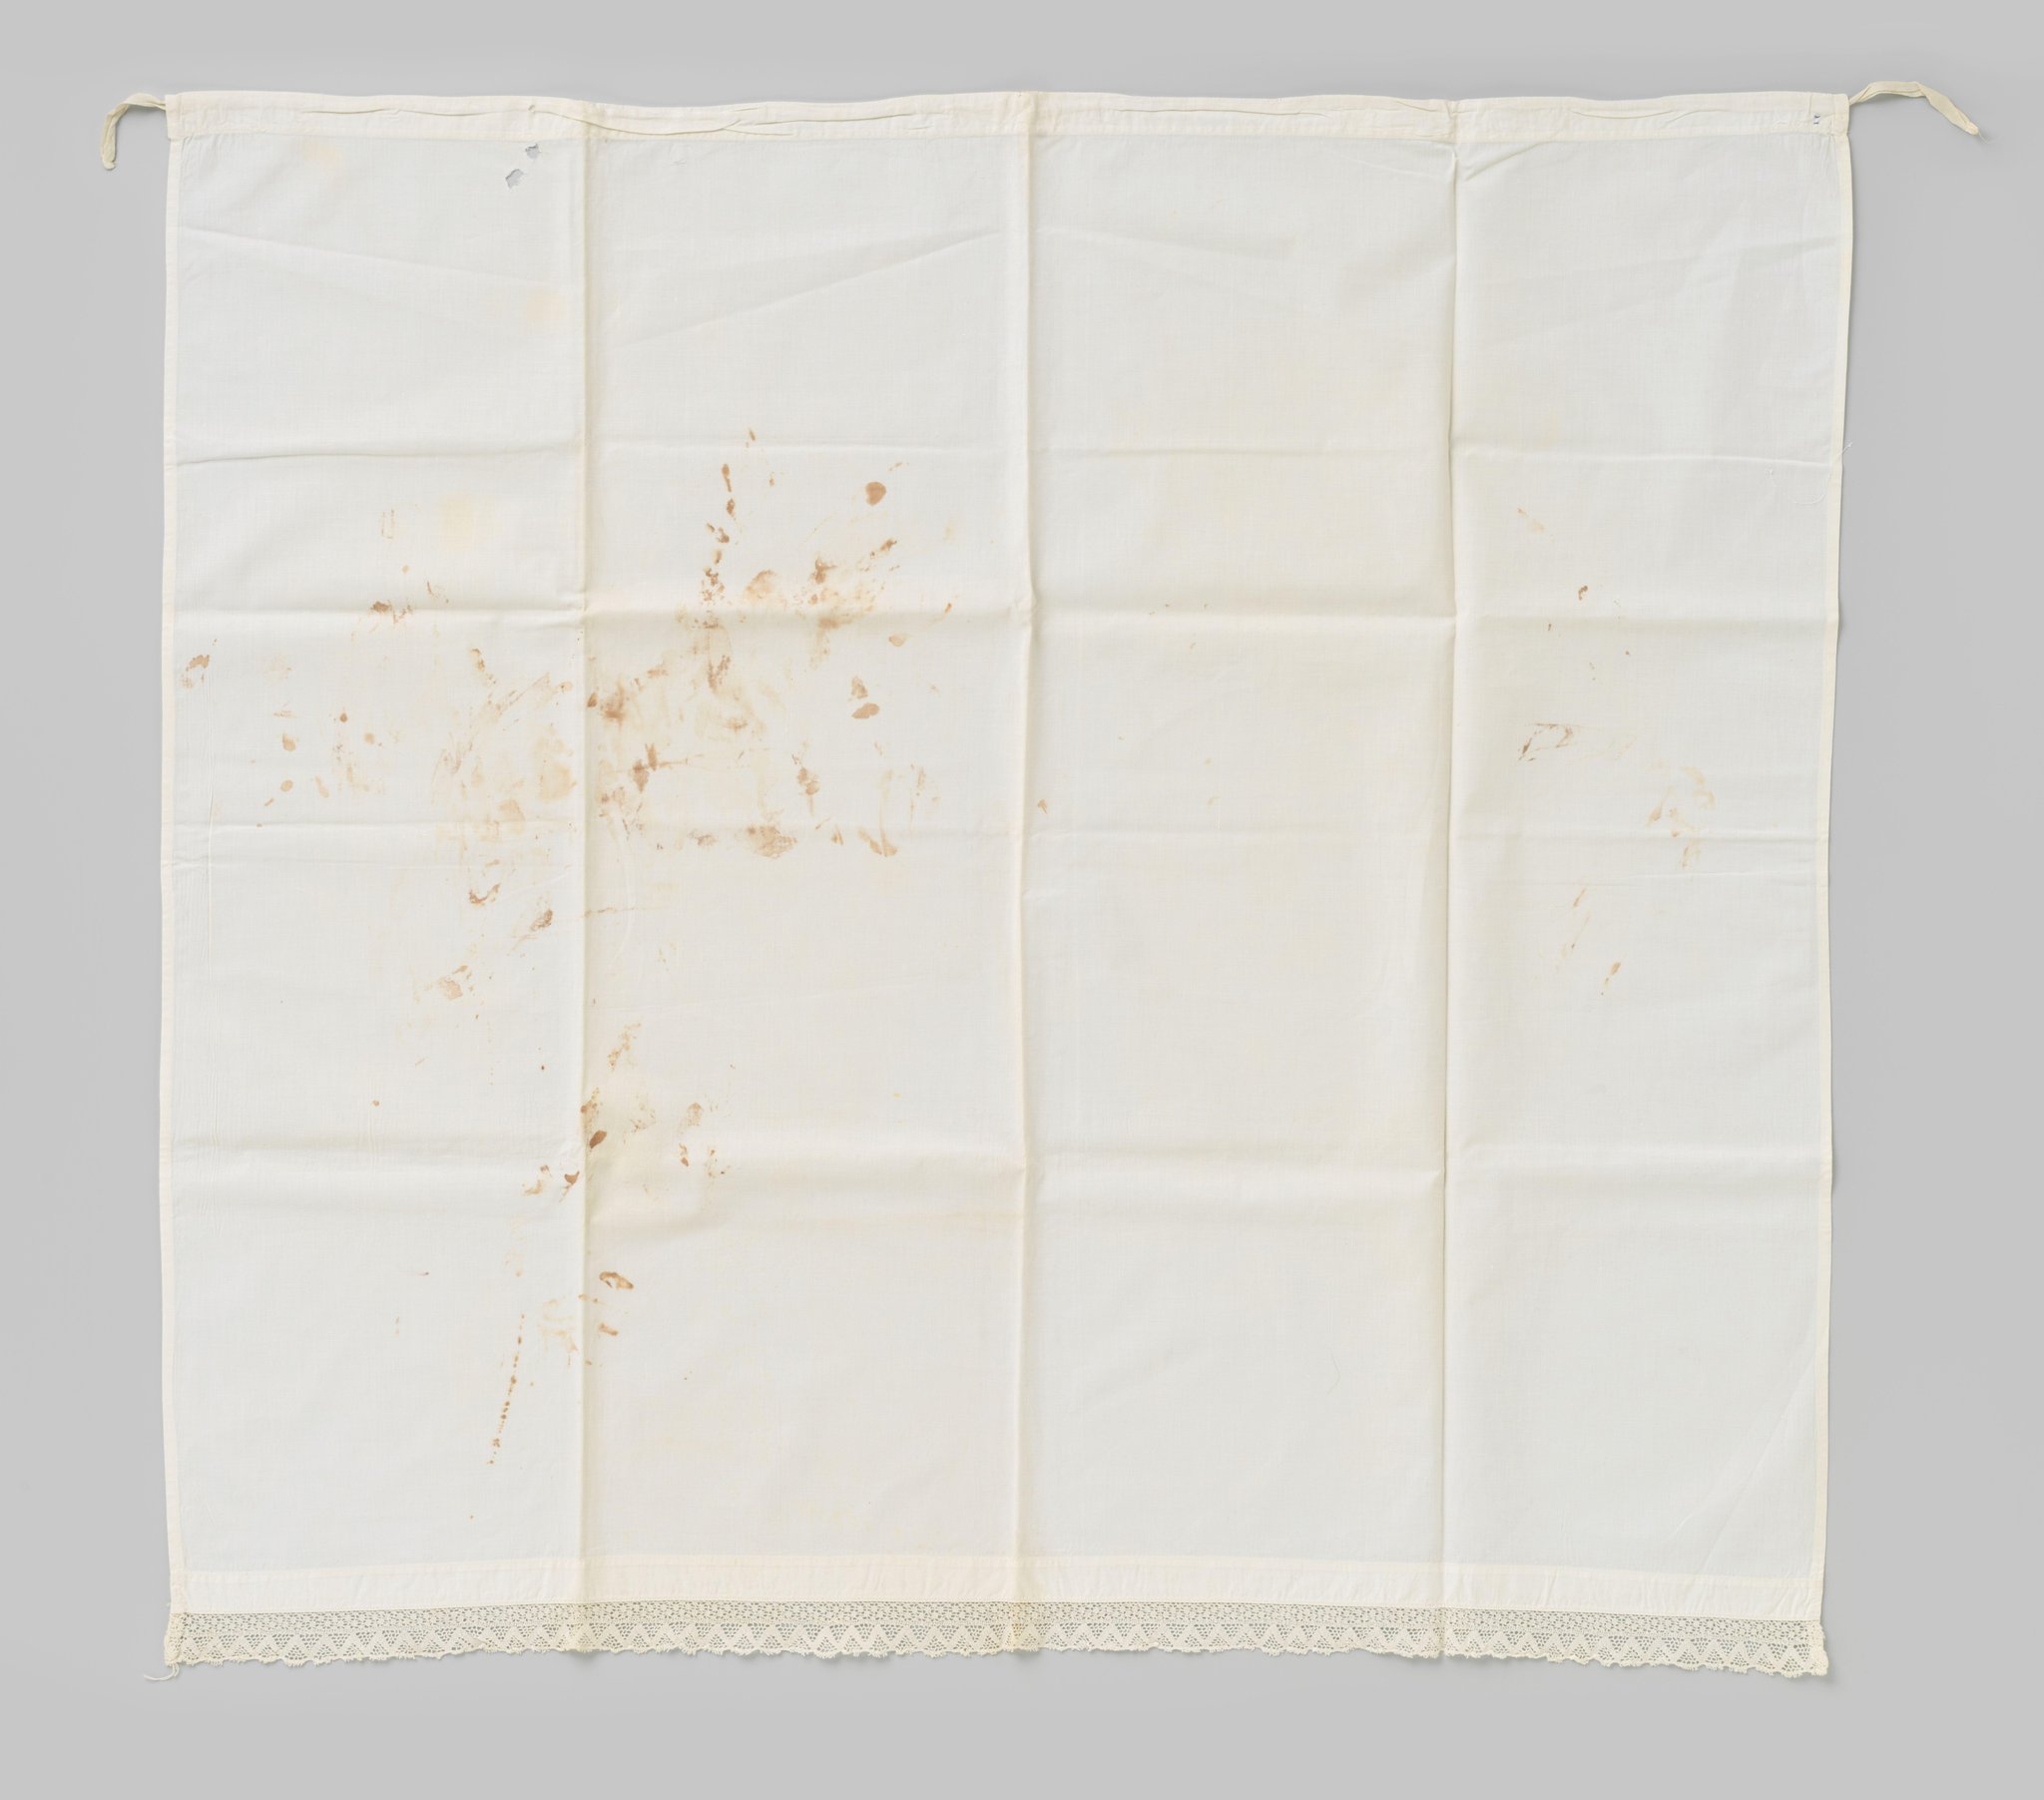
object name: apron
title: Gordijn of schort van witte katoen, aan de onderzijde afgezet met een rand gehaakte kant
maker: Anonymous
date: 1800-1900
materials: cotton, linen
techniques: crochet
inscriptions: mark: ‘V I X’, mark: ‘106’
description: Gordijn of schort van witte katoen, aan de ondrzijde afgezet met een rand gehaakte kant. Aan de bovenzijde voorzien van een brede zoom waardoor een wit linnen (?) bandje. Gemerkt op de bovenzoom: 106 (machinaal ingeweven).